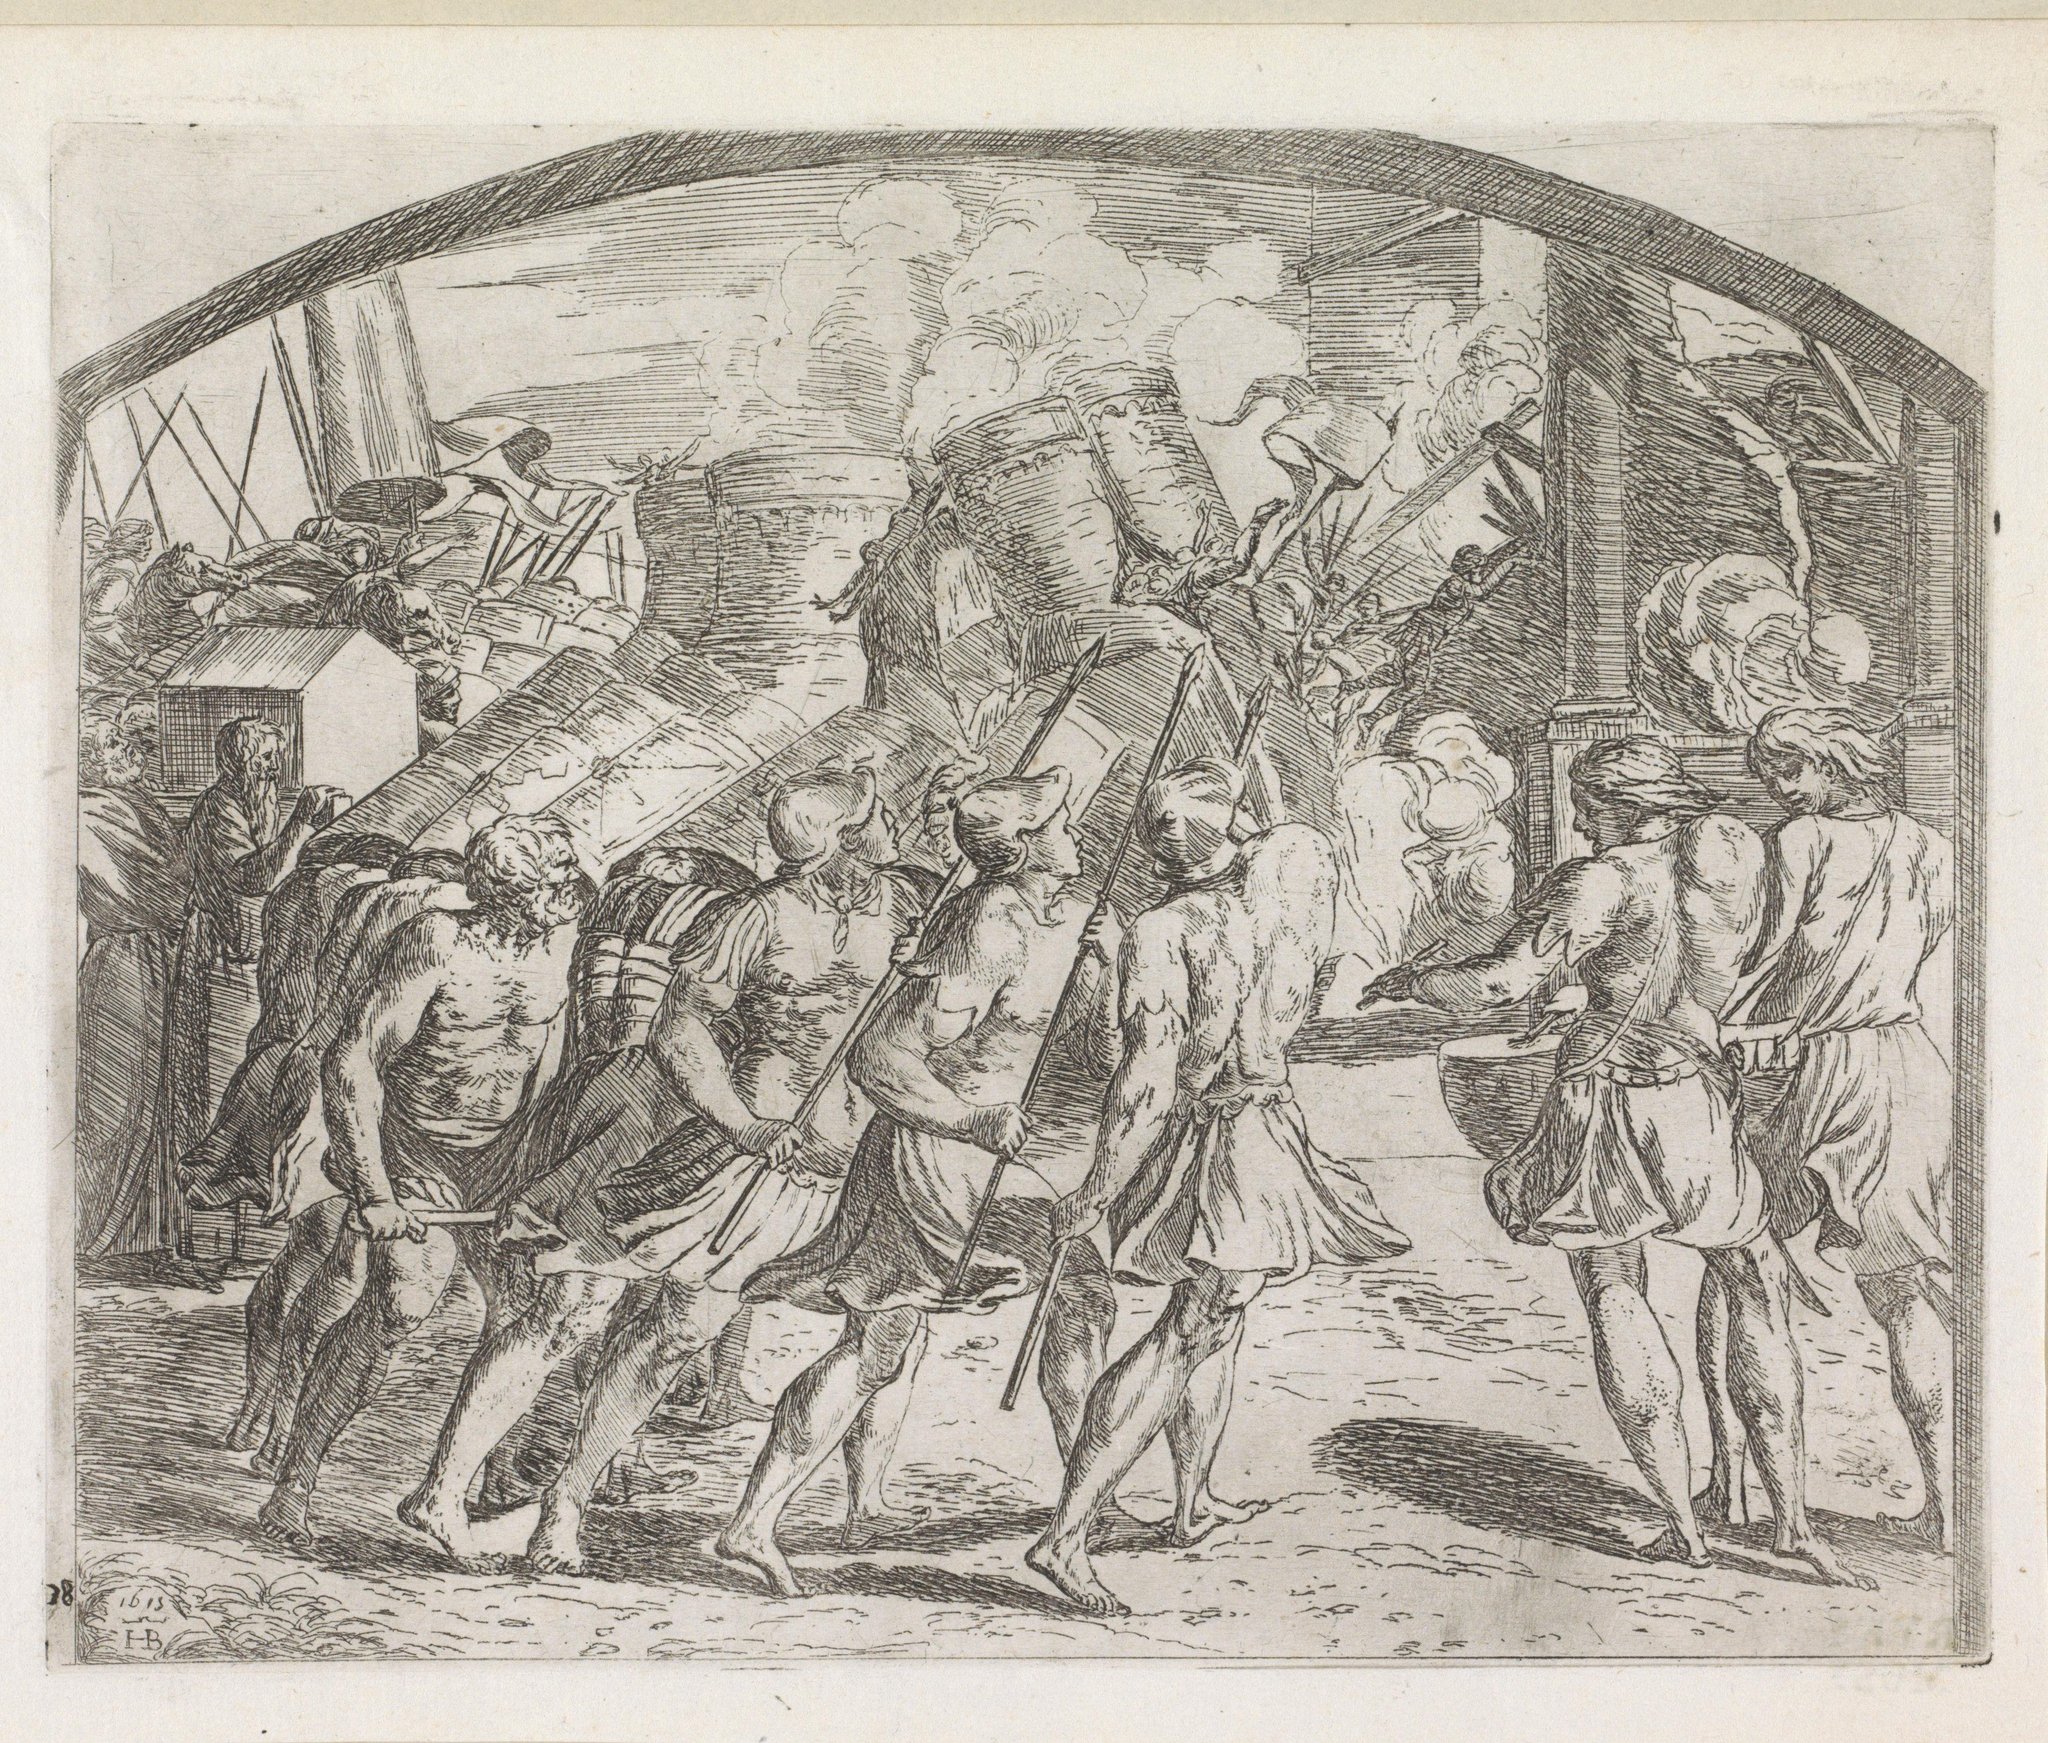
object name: print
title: Val van Jericho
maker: orazio borgianni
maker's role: print maker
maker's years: 1578-1616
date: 1615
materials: paper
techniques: etching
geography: italy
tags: the fall of jericho (joshua 6), ark of the covenant ~ jewish religion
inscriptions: collector's mark: Lugt 2165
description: De muren van de stad Jericho storten in. Op de voorgrond soldaten. Links priesters die de Ark des Verbonds dragen.